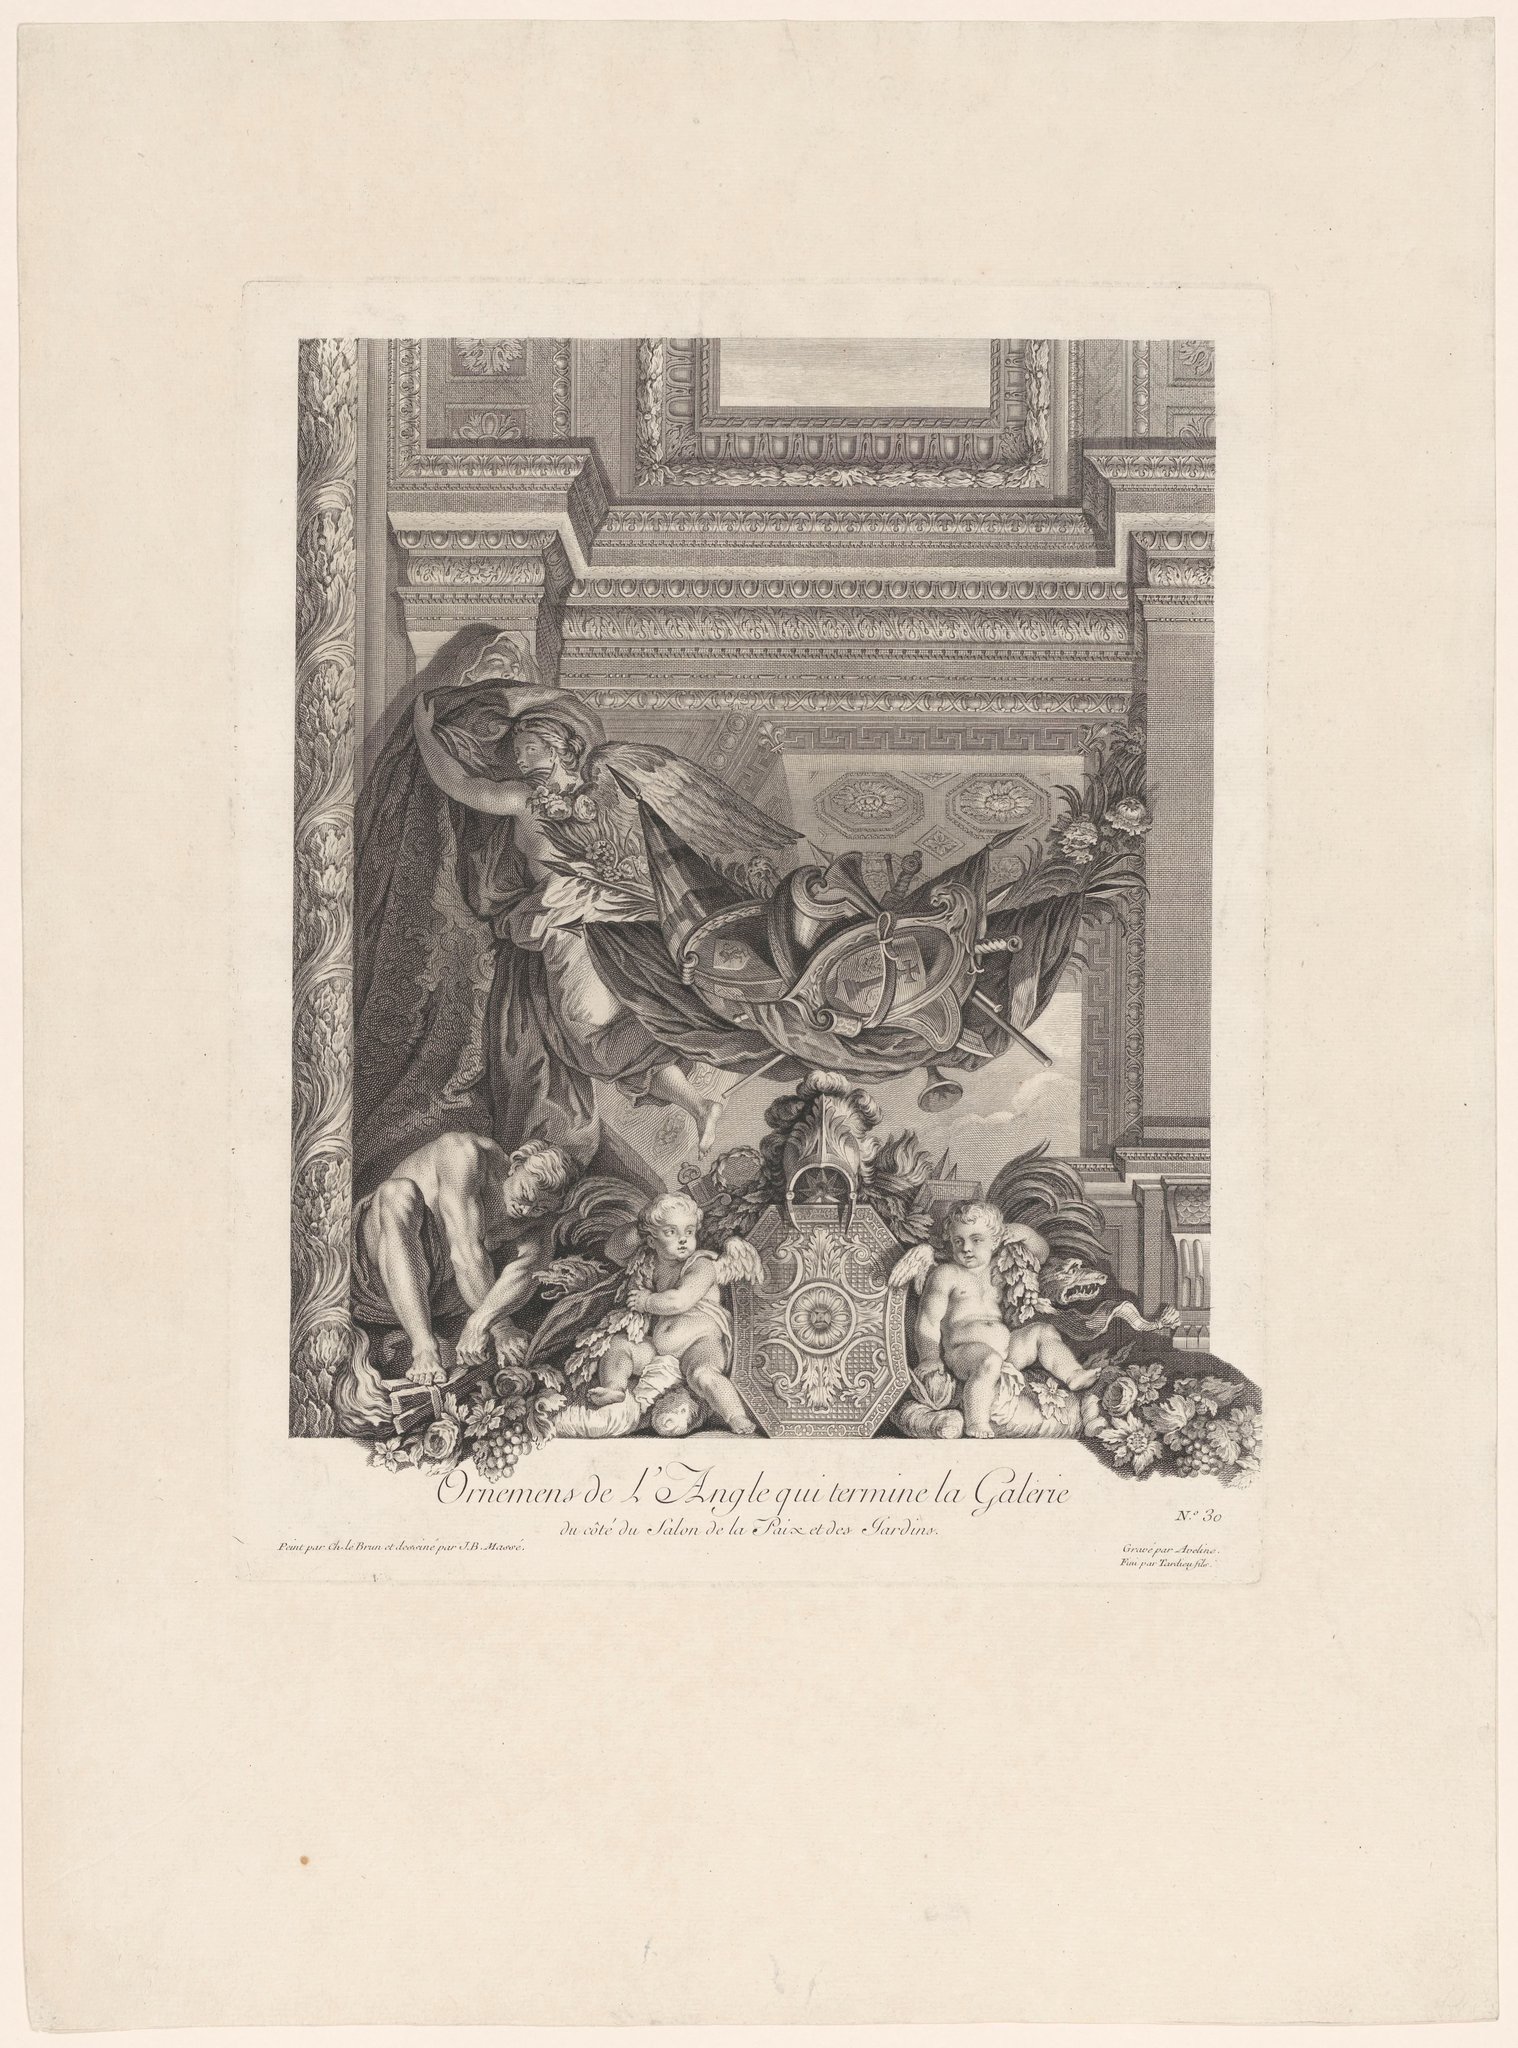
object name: print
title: Ornemens de l'angle qui termine la galerie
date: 1752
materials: paper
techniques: engraving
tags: (decorated) ceiling, cupids: 'amores', 'amoretti', 'putti'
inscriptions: collector's mark: Lugt 2228